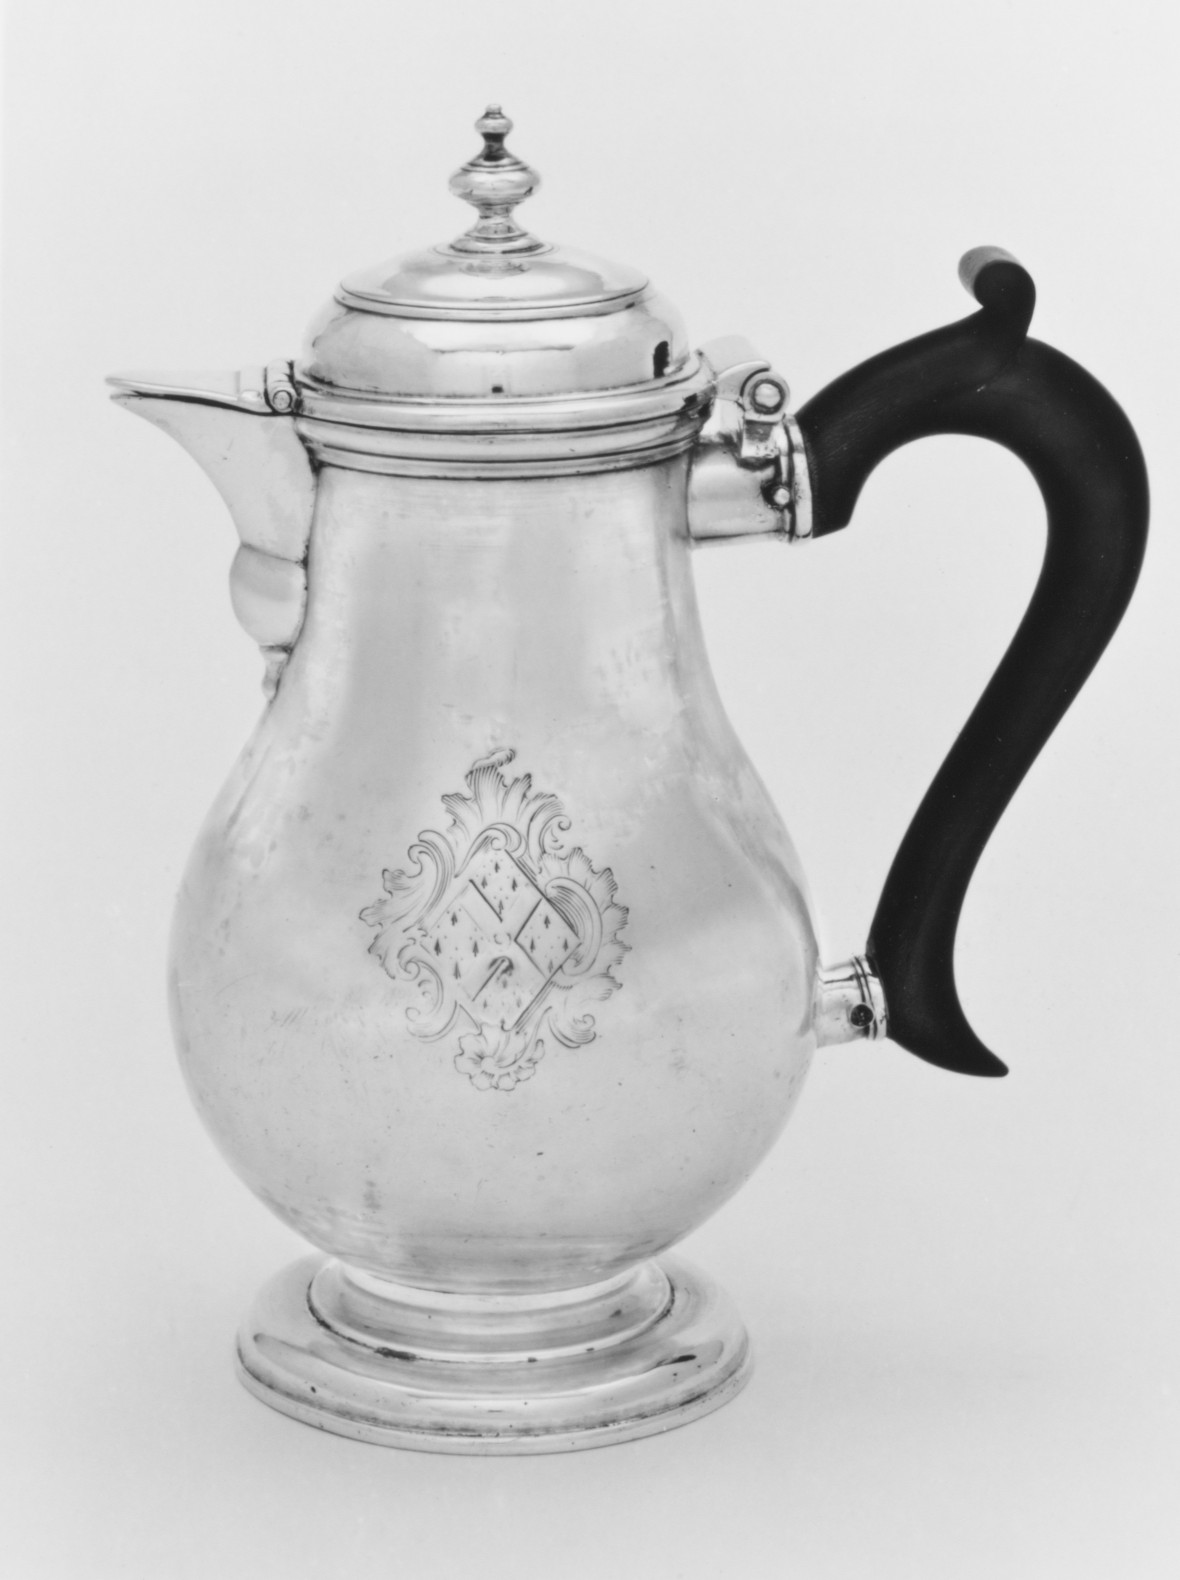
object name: jug with cover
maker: john chartier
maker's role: maker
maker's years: 1697-1715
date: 1711-1712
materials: silver, wood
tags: coat of arms